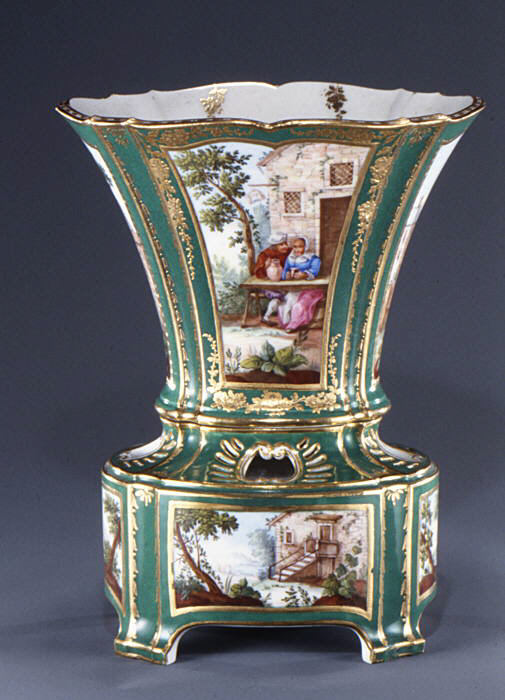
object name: vase stand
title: Flower vase with stand (vase hollandais nouveau) (one of a pair)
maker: sèvres manufactory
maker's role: manufactory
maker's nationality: french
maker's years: 1740-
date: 1761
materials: soft paste porcelain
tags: houses,men,women